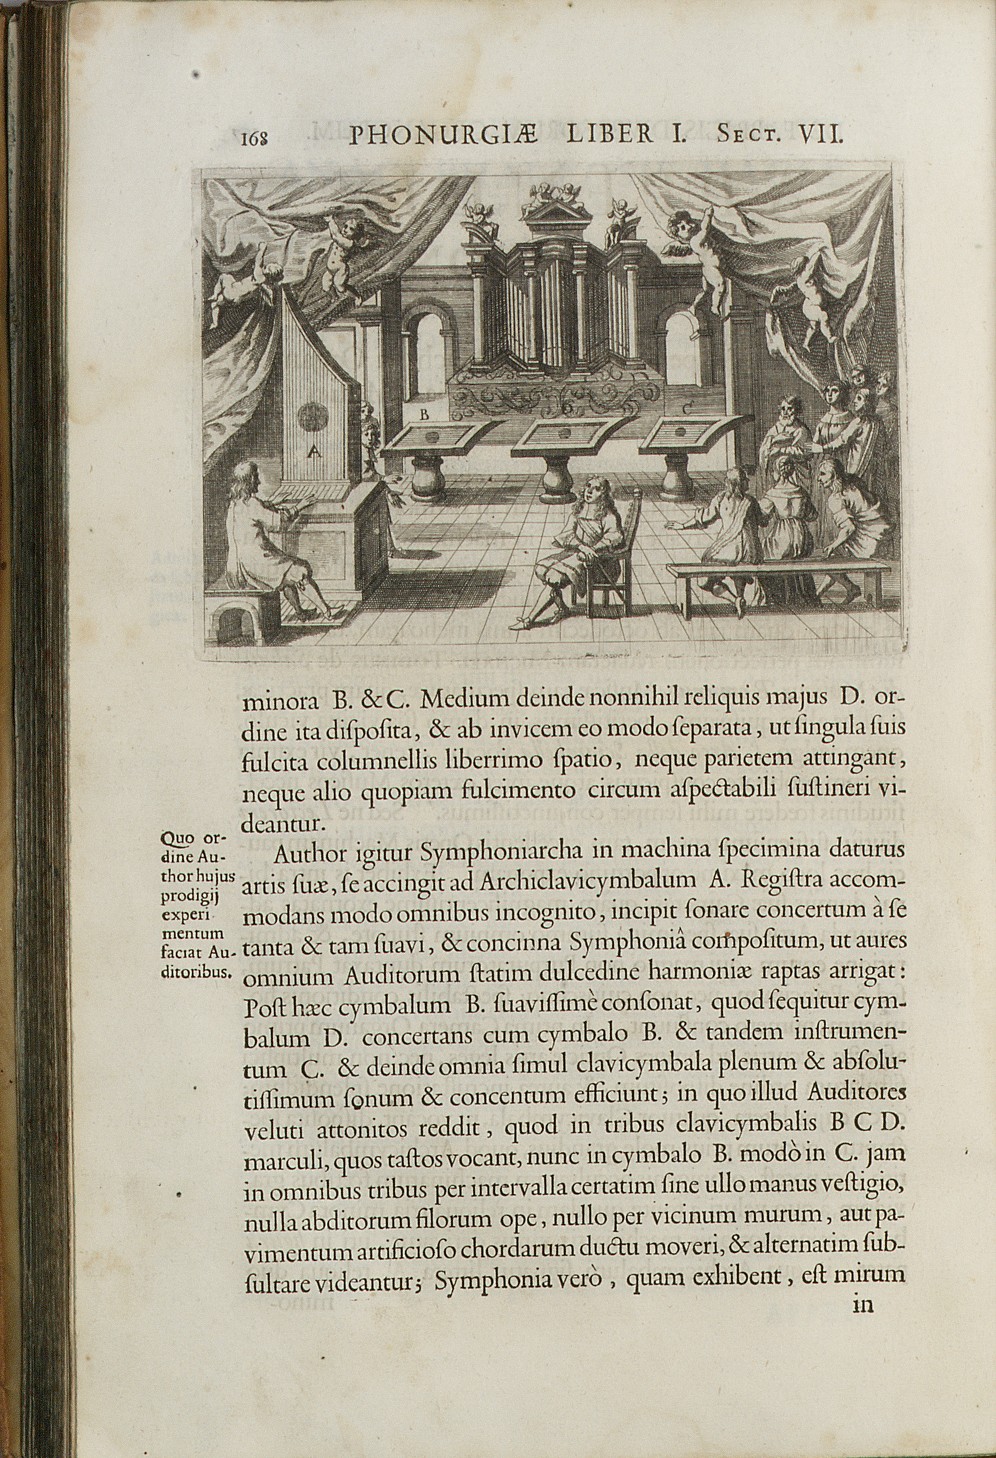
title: Phonurgia nova, sive conjugium mechanico-physicum artis & natvrae paranympha phonosophia concinnatum . . .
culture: campidanese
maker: athanasius kircher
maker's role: author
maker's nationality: german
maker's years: 1602-1680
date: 1673